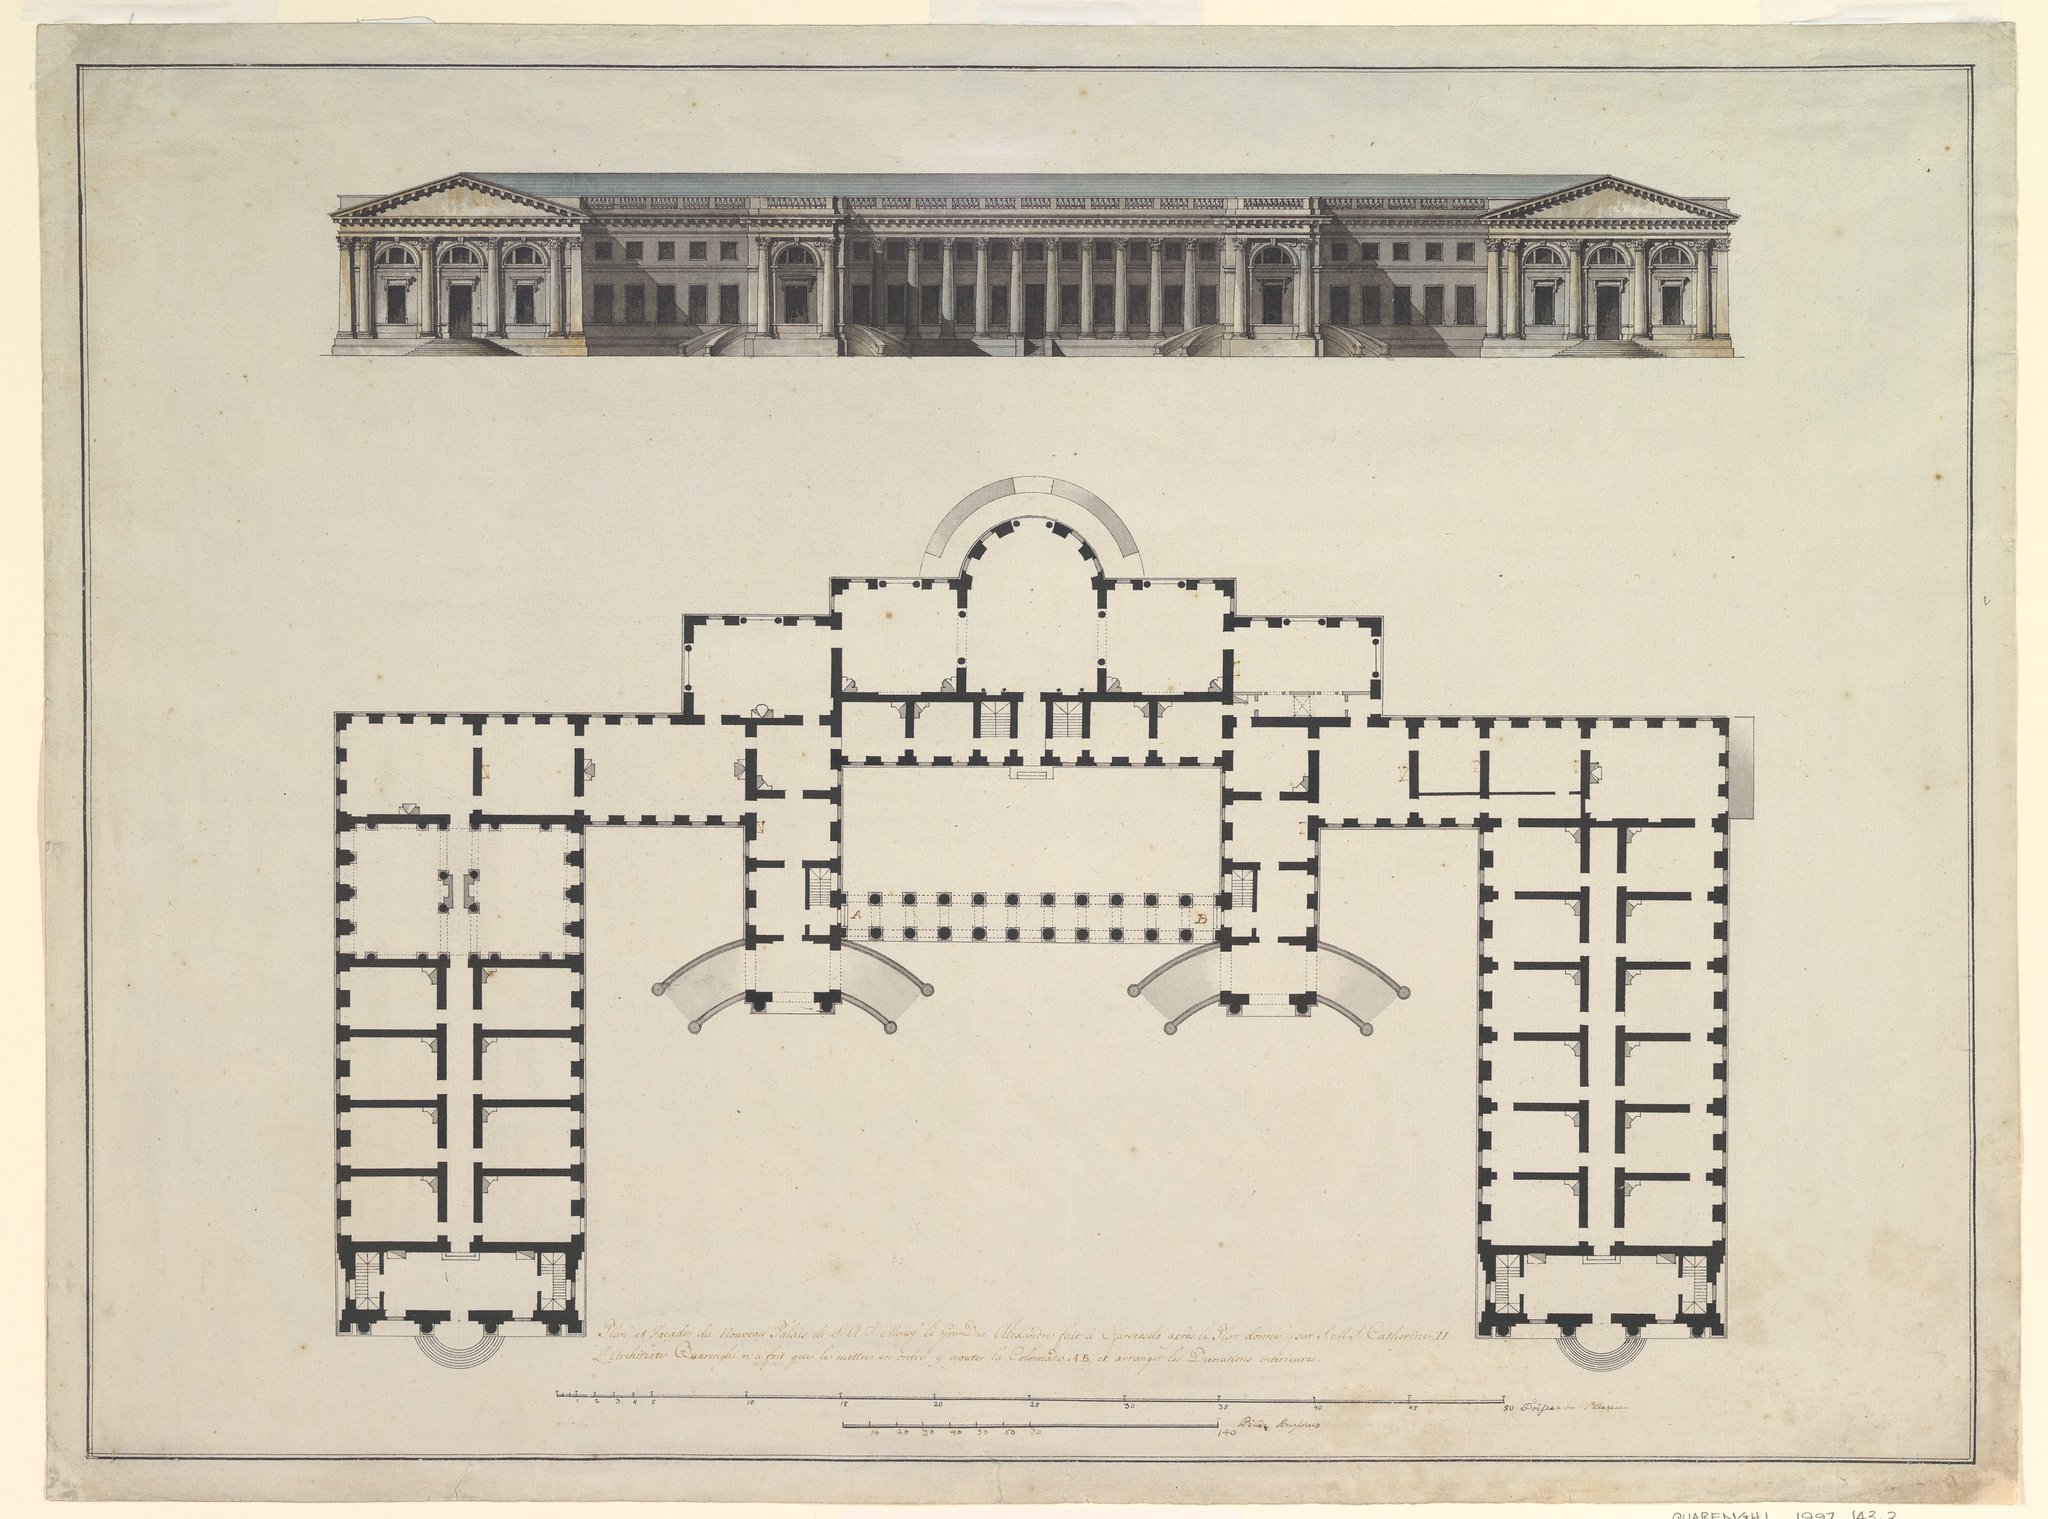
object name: drawing ornament architecture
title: North Elevation and Ground Plan of the Alexander Palace at Tsarskoe Selo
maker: giacomo quarenghi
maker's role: artist and architect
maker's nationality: italian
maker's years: 1744-1817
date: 1792-1796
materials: graphite, ink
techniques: brush, pen, wash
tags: architecture,palaces